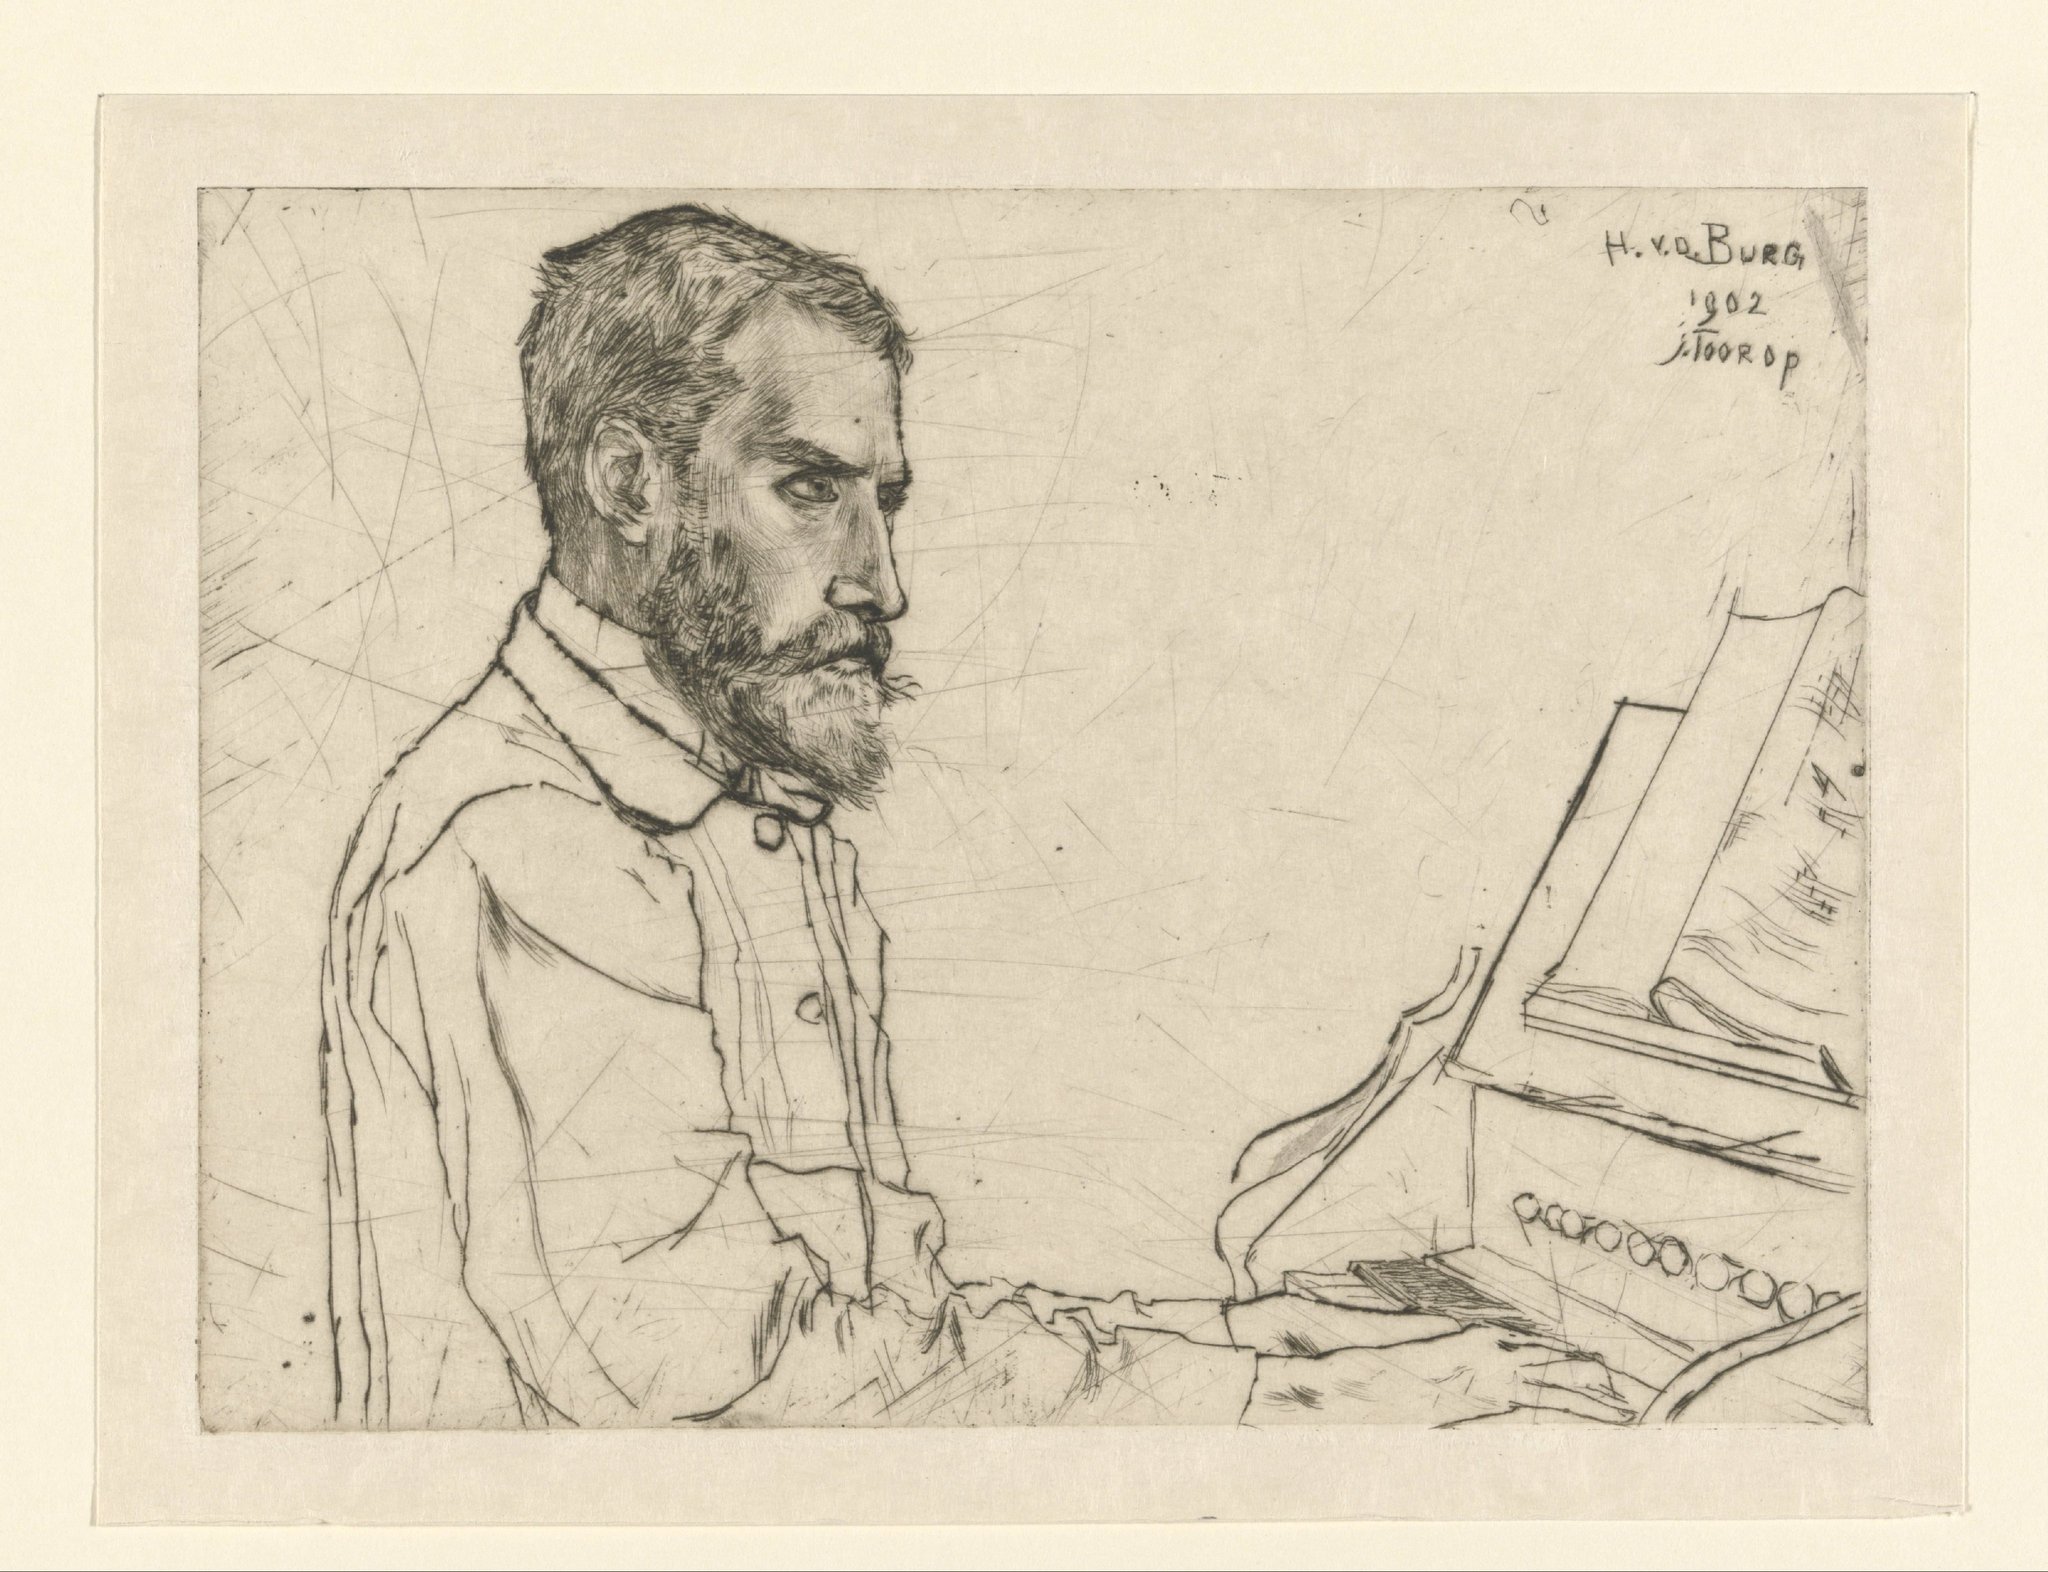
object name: print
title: Portret van Henri van den Burg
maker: jan toorop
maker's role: draughtsman, painter, print maker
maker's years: 1858-1928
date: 1902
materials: paper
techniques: drypoint, intaglio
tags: amsterdam, deventer, historical persons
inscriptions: collector's mark: Lugt 2228